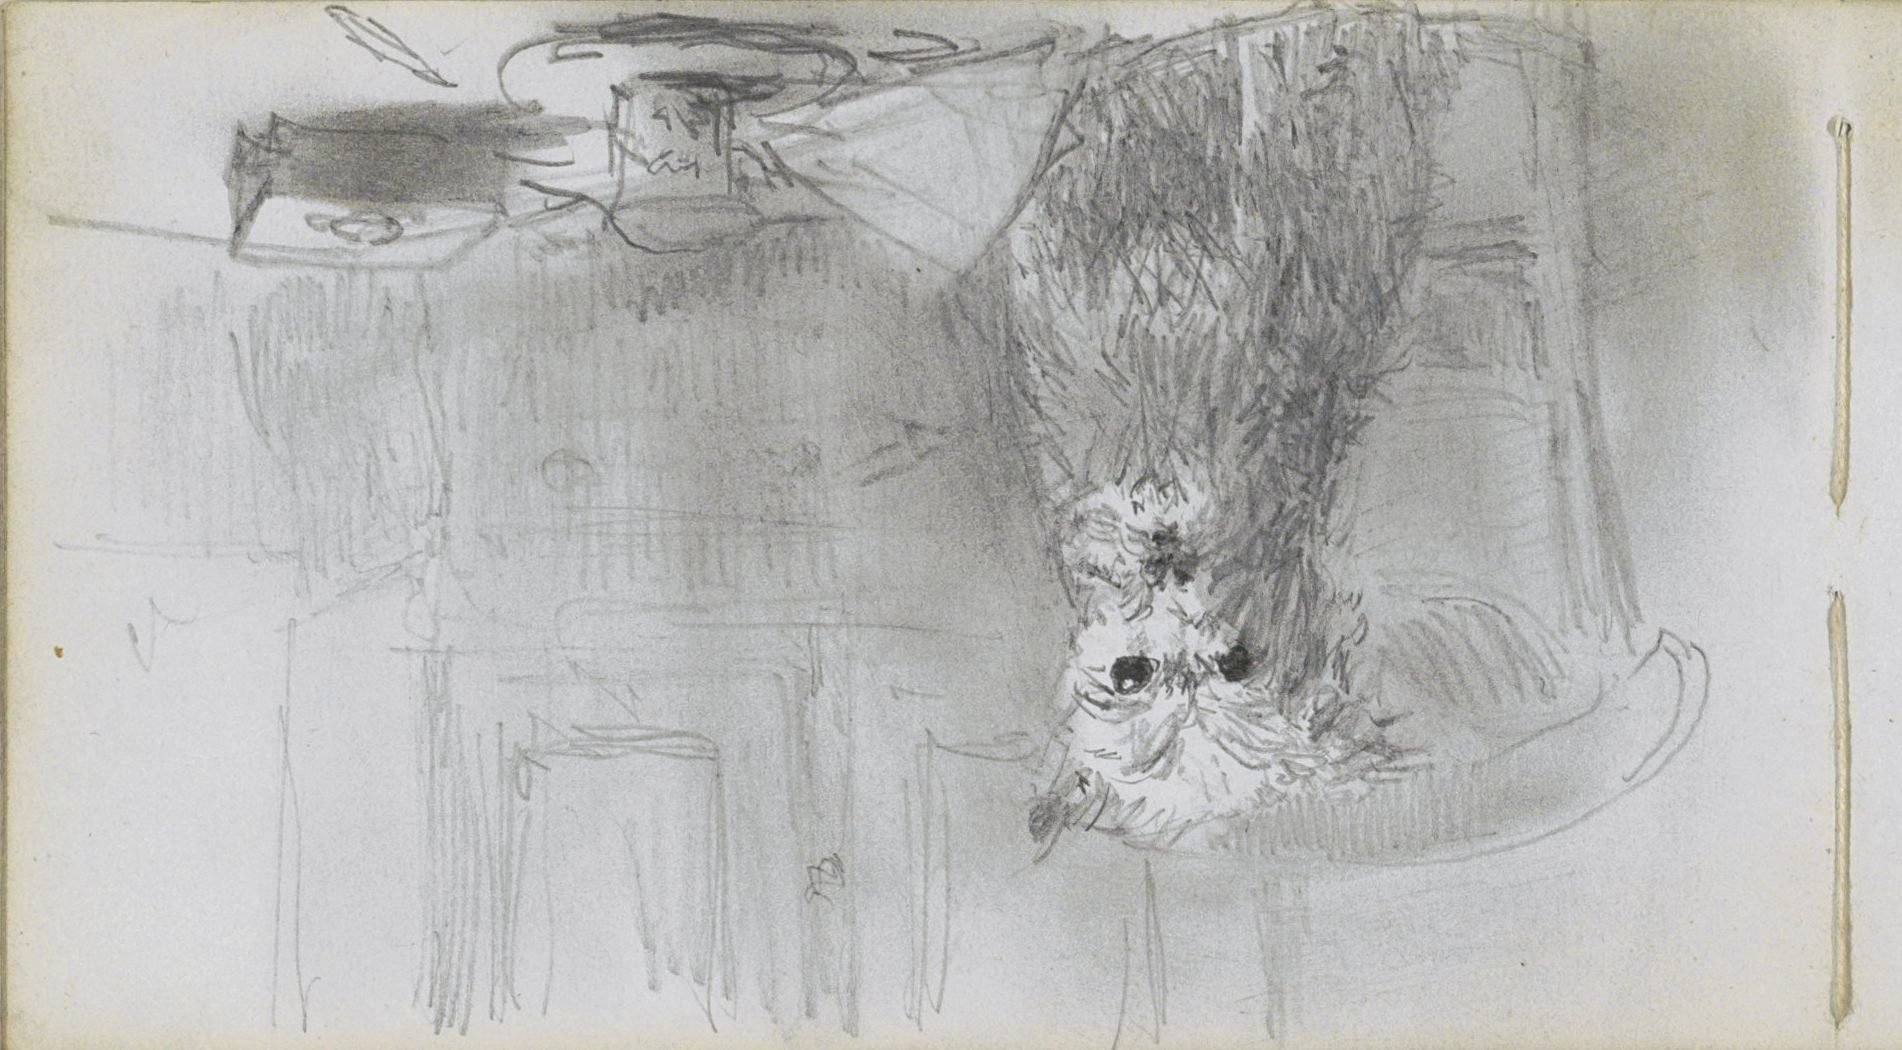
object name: sketchbook leaf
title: Hond zittend aan een tafel in een interieur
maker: johan hendrik weissenbruch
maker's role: draughtsman, painter, print maker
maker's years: 1824-1903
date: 1834-1903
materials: paper, pencil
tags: table, interior of the house, dog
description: Blad 31 verso uit een schetsboek met 39 bladen.